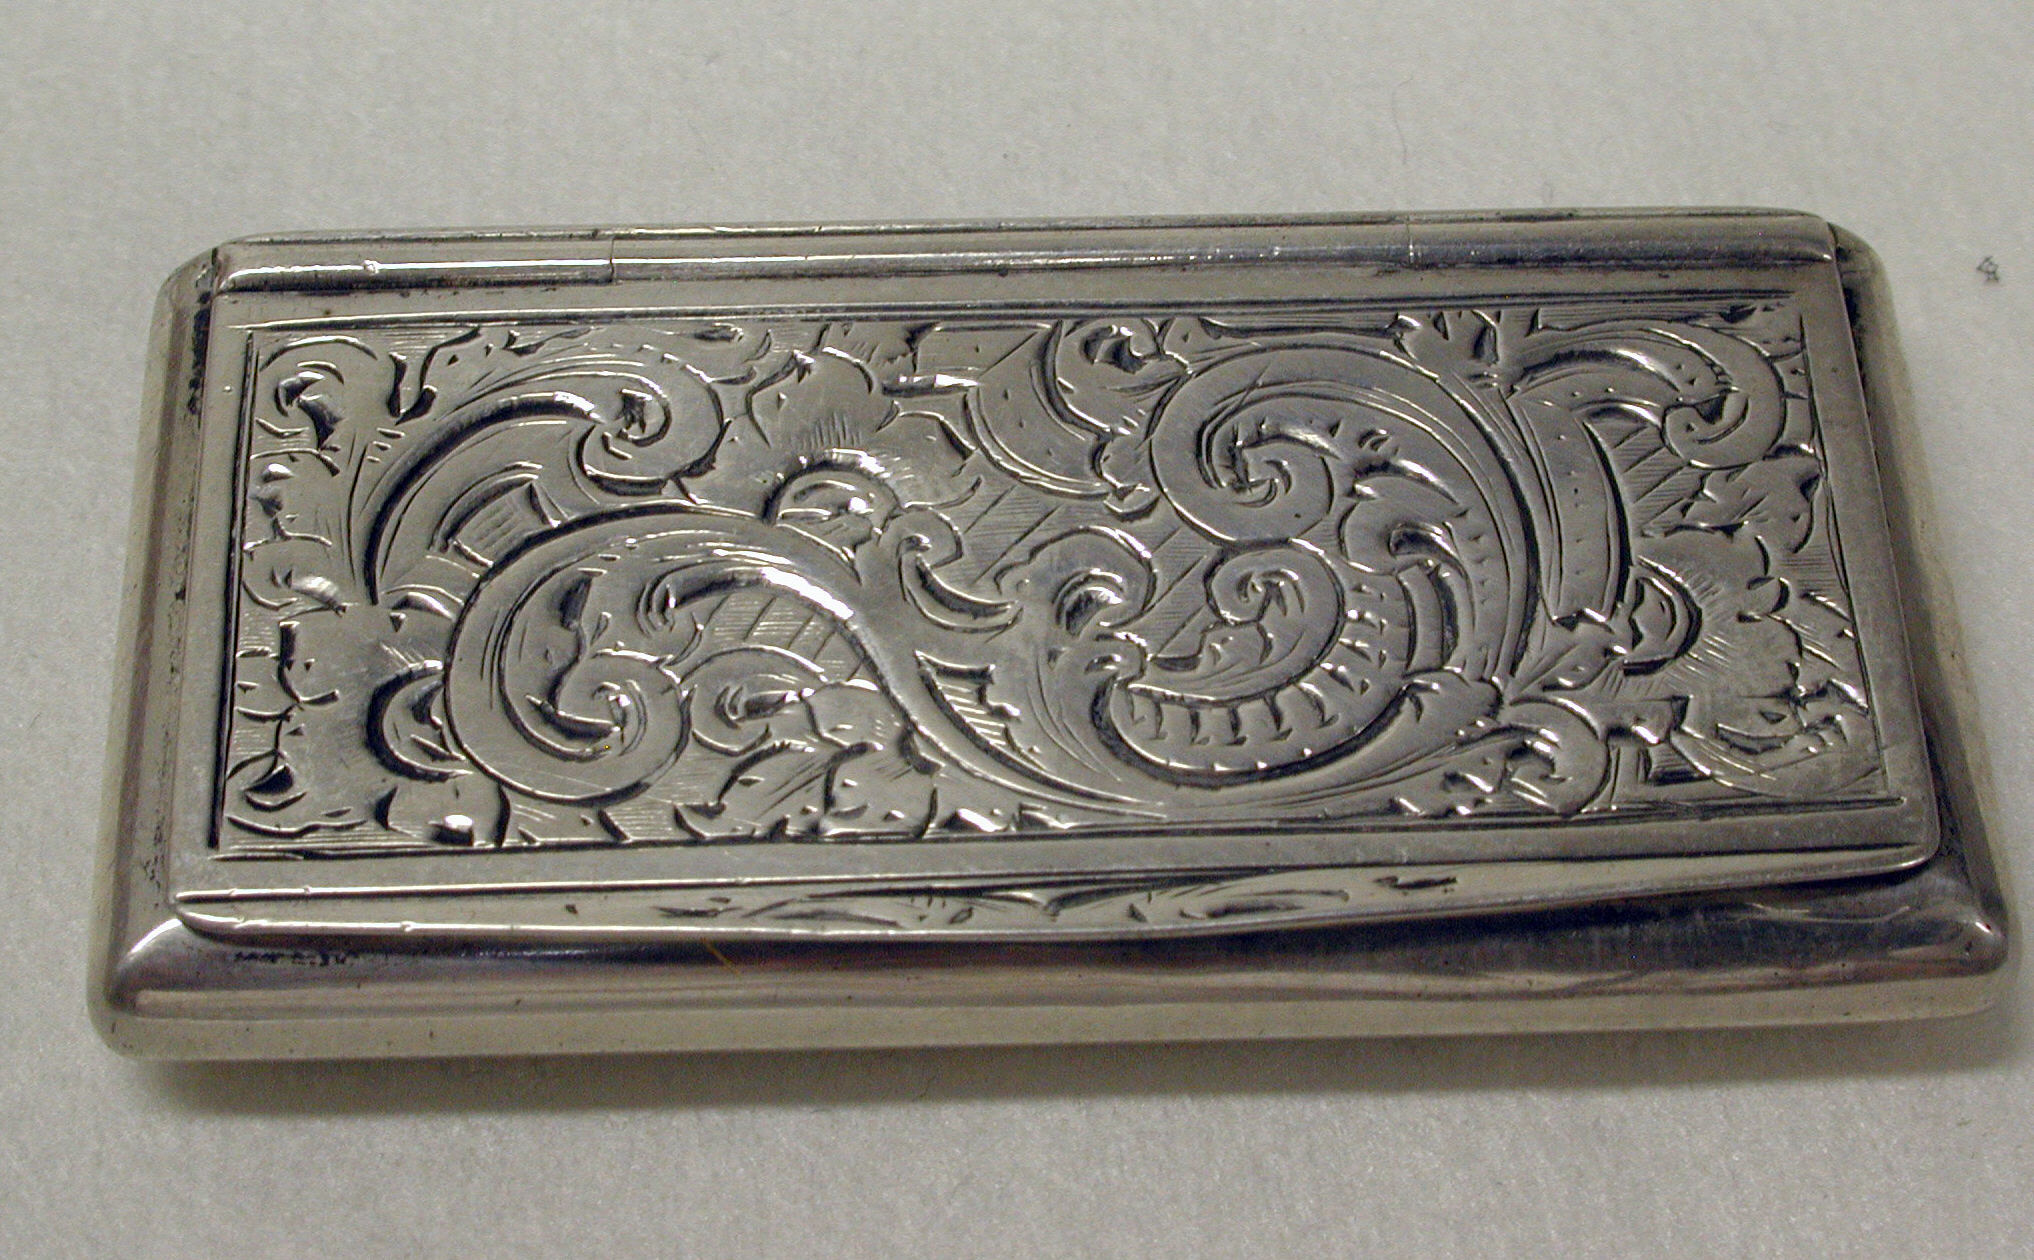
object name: match case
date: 1867-1900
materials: silver